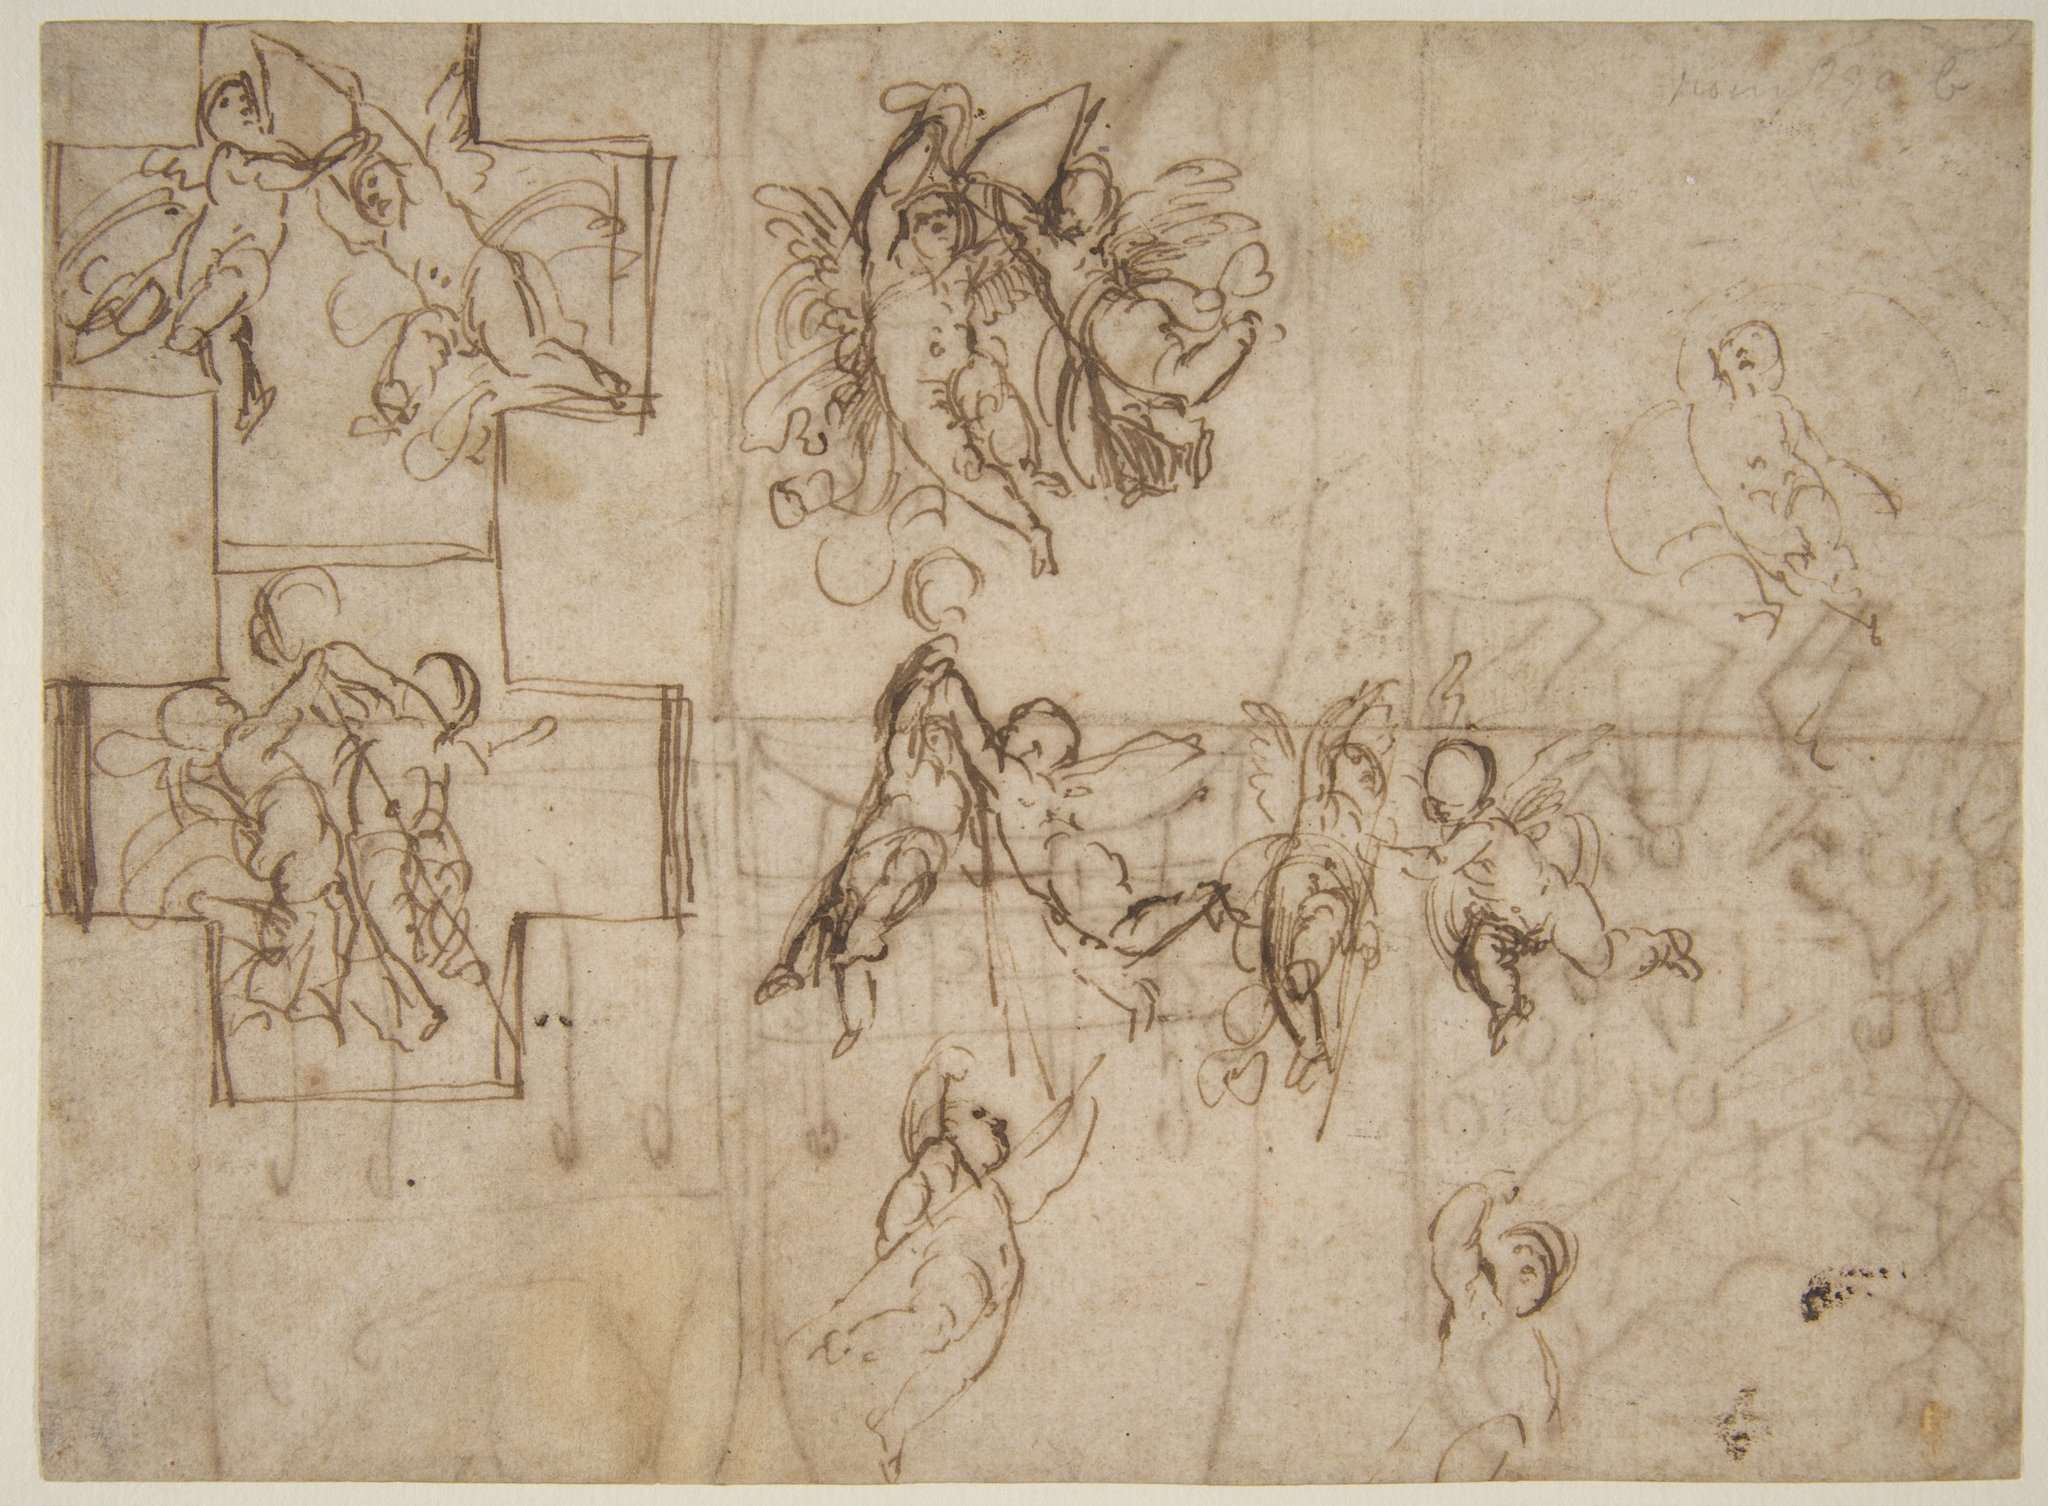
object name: drawing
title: Studies of Flying Putti (recto); Composition Studies (verso)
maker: guido reni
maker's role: artist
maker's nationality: italian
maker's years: 1575-1642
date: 1575-1642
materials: chalk, ink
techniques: pen